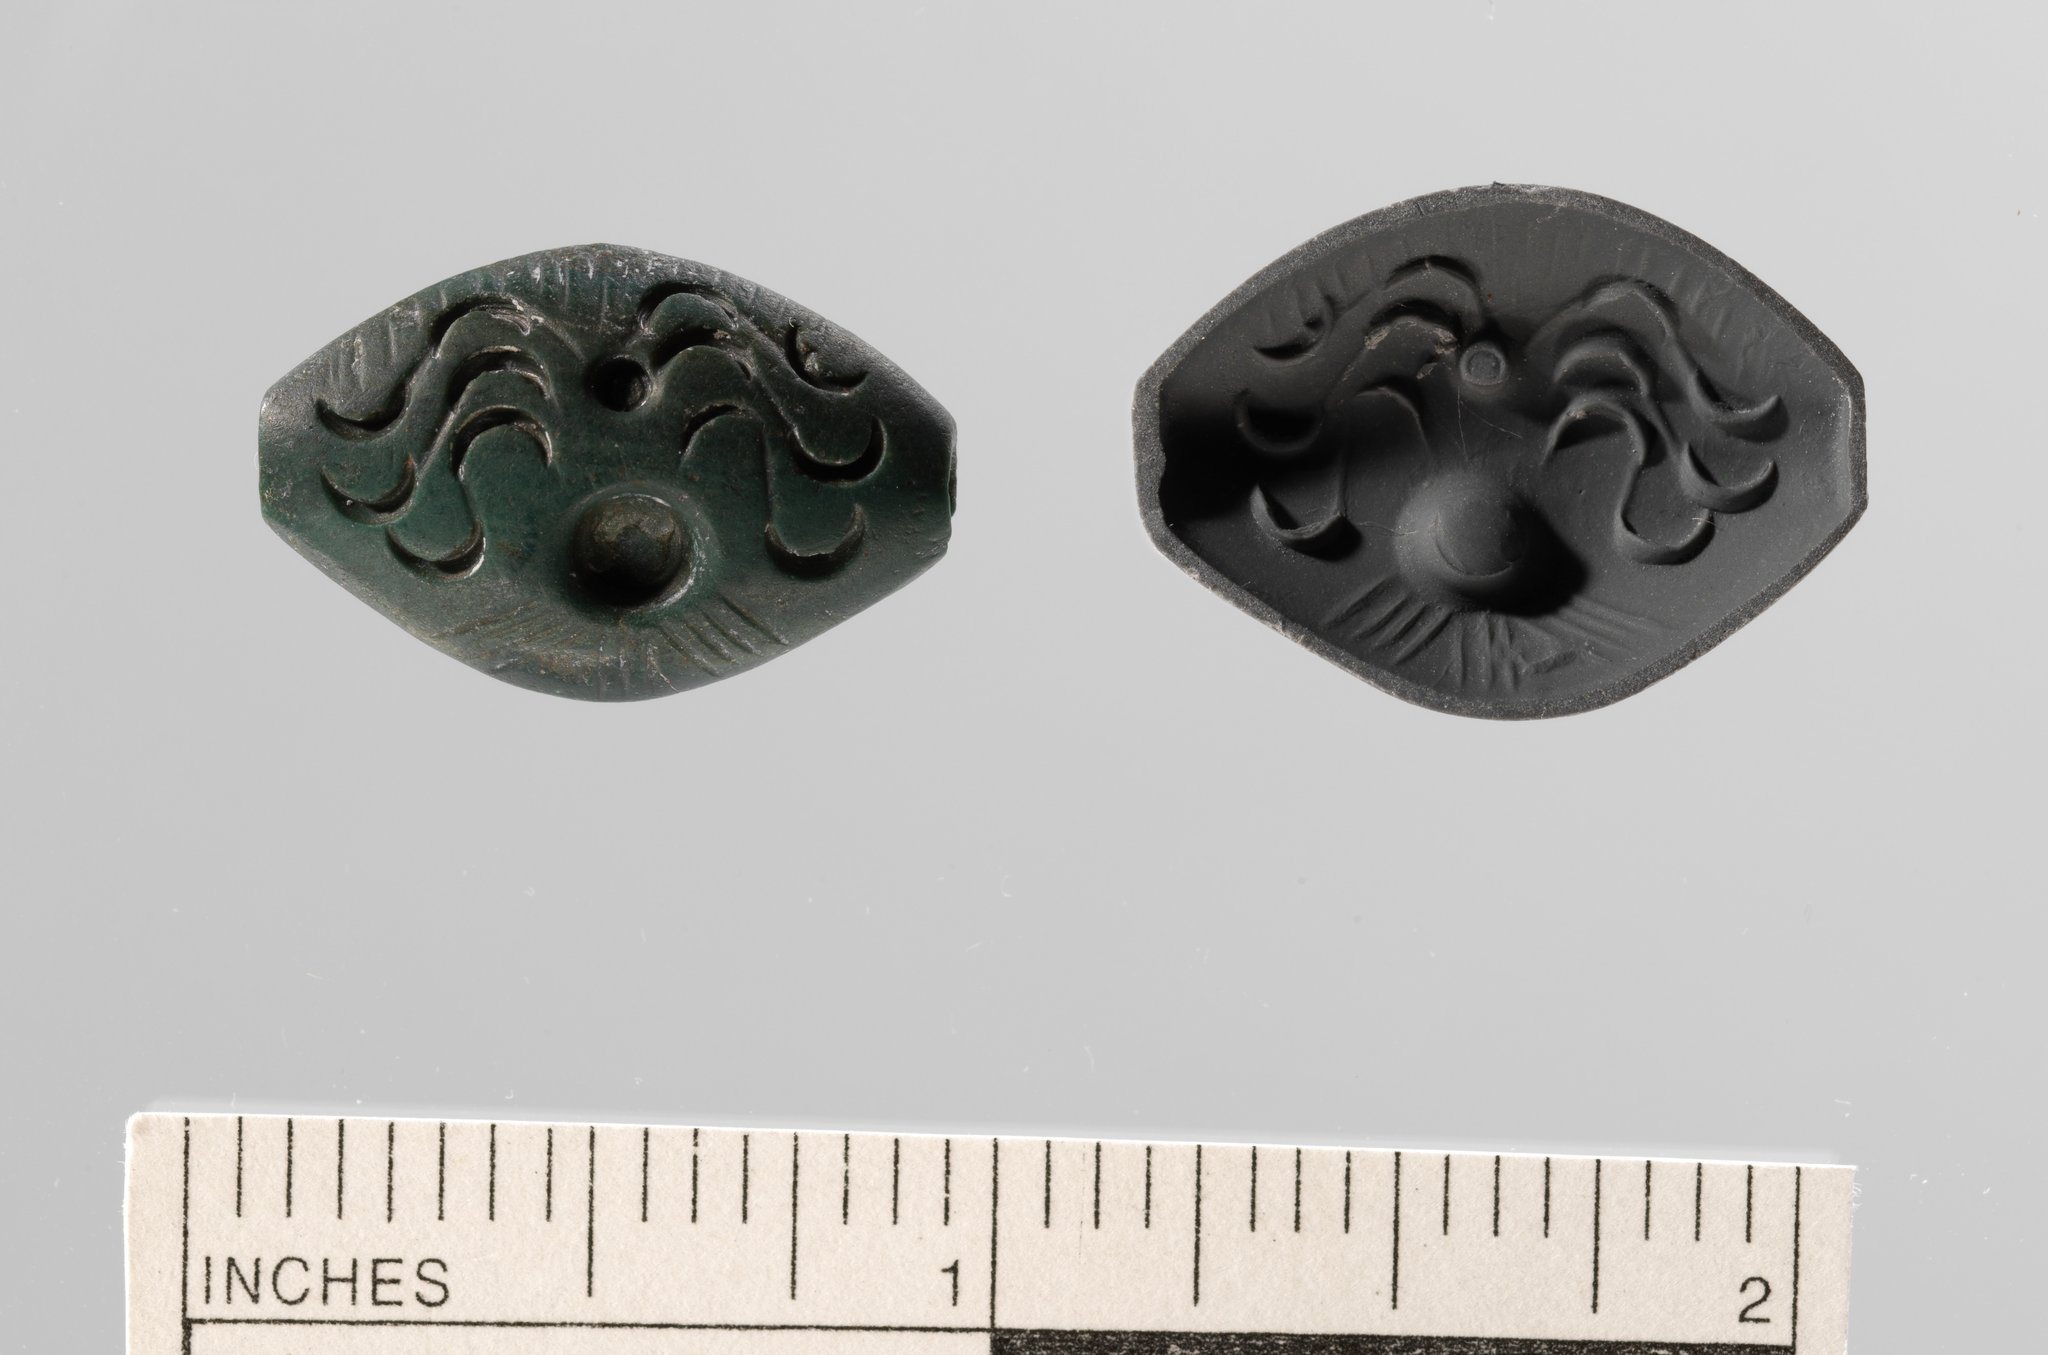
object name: seal, amygdaloid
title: Jasper Amygdaloid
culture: minoan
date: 1650-1500 BCE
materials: jasper